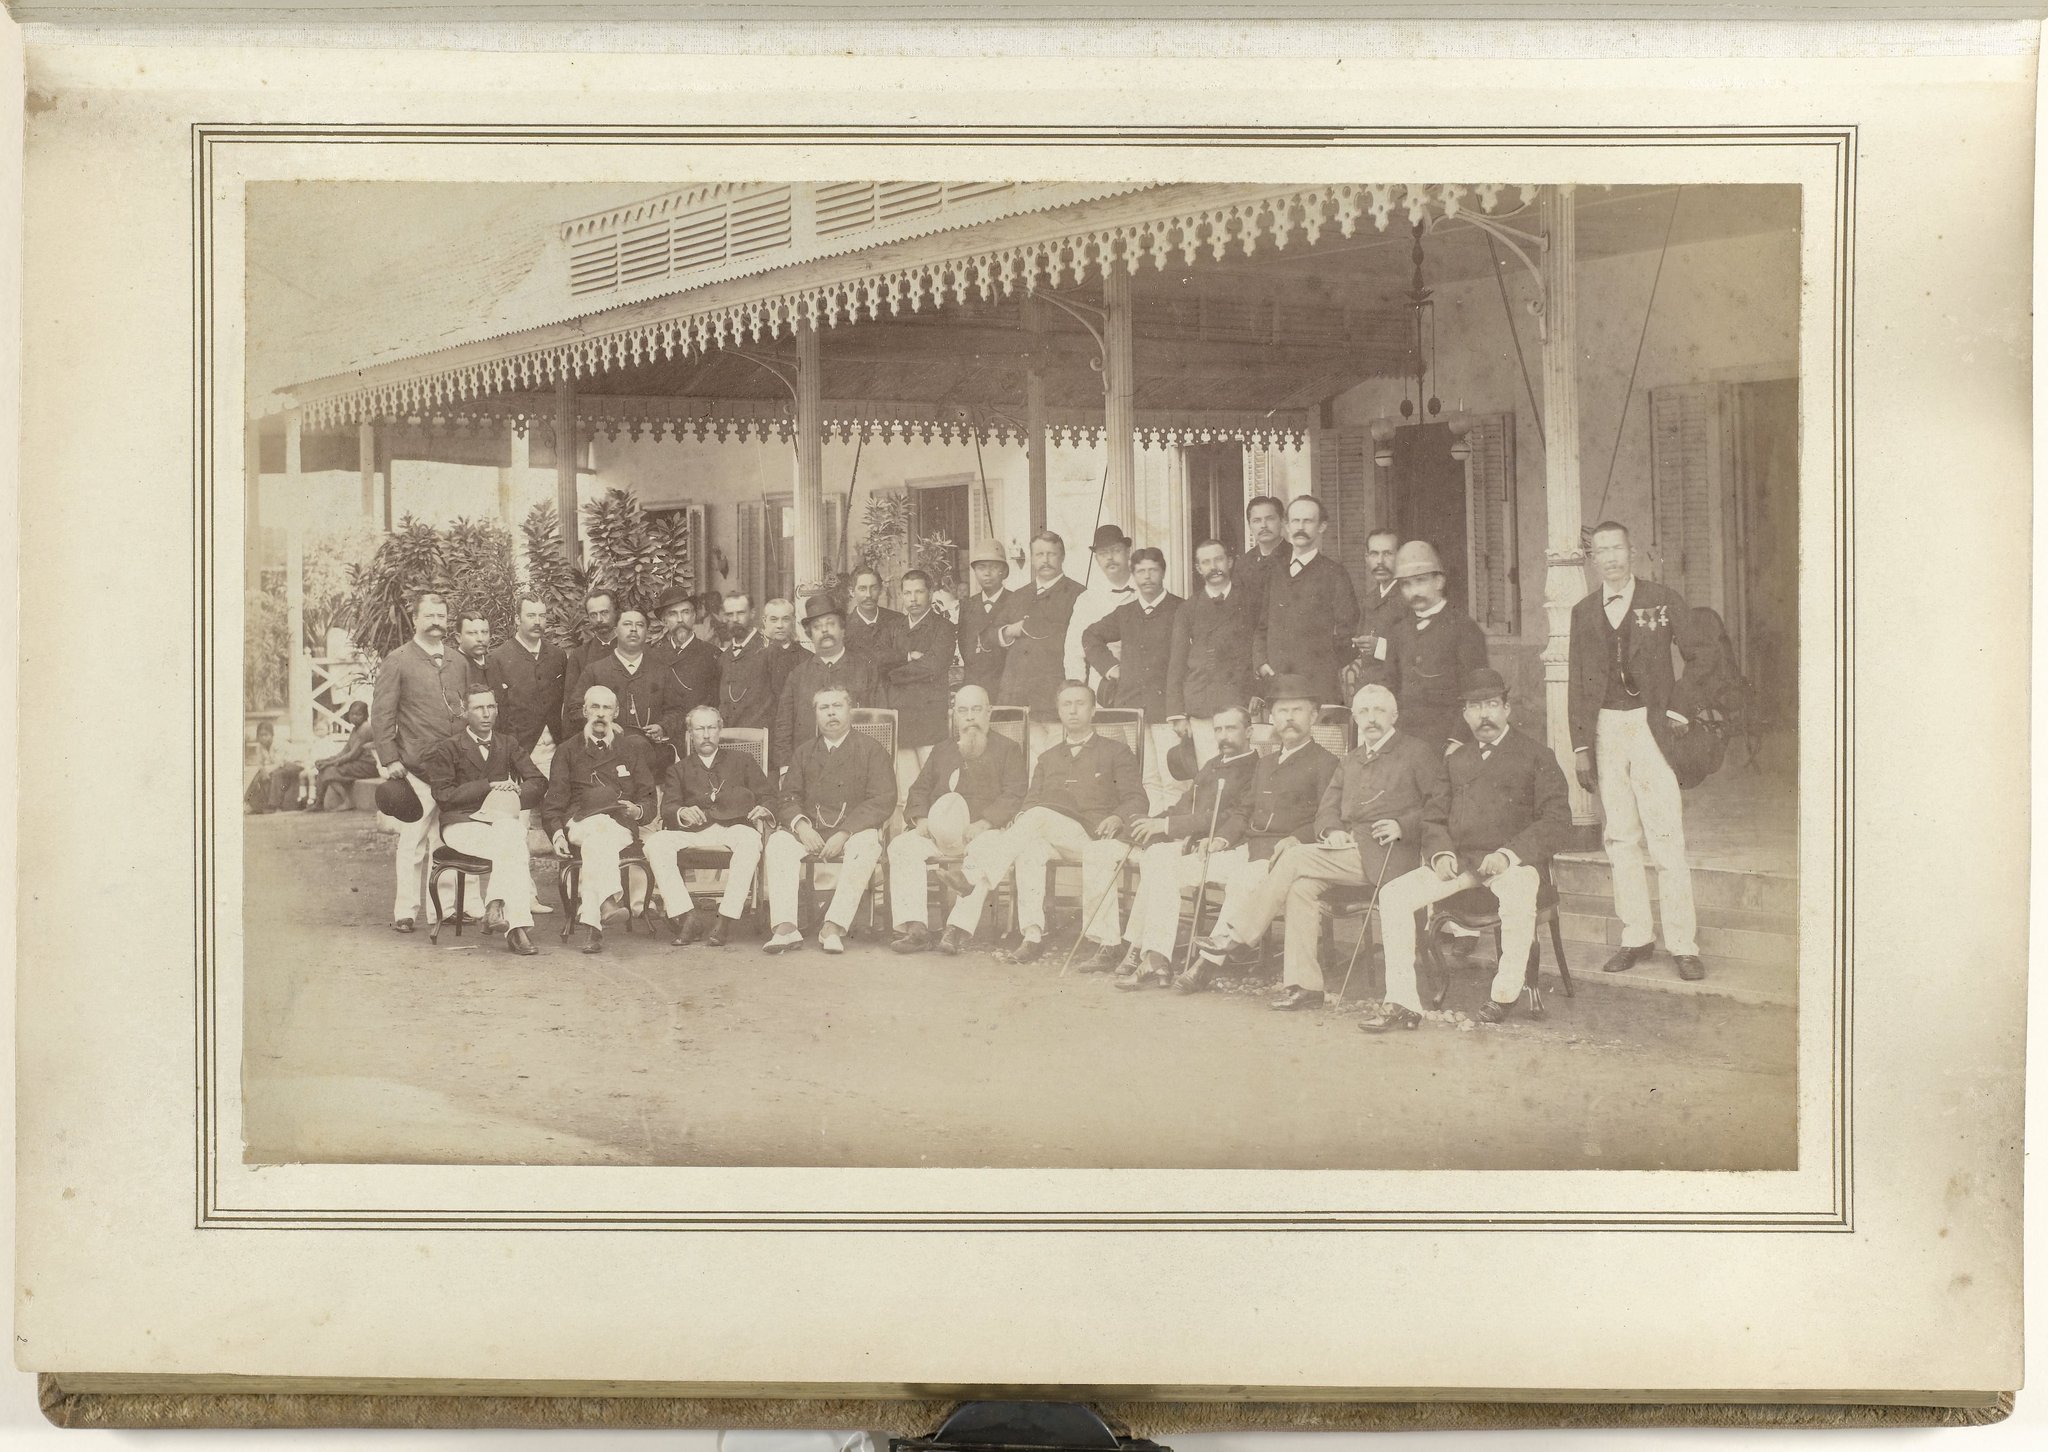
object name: photograph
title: Groepsfoto van de aanbieders van het fotoalbum van J.M. Pijnacker Hordijk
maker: kassian céphas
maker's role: fotograaf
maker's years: 1845-1912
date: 1888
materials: photographic support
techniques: albumen print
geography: jogjakarta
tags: anonymous historical persons portrayed in a group, in a group-portrait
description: Groepsfoto van de vrienden en kennissen die het fotoalbum hebben aangeboden aan J.M. Pijnacker Hordijk, 2 juli 1888. Twee rijen mannen zittend en staand voor het huis van Wieseman (schoonvader van J.M. Pijnacker Hordijk) in Jogyakarta. Staande in het midden Pijnacker Hordijk met de hand in de jas gestoken. Later toegevoegd aan het fotoalbum aangeboden aan J.M. Pijnacker Hordijk bij zijn vertrek uit Jogyakarta in 1886.